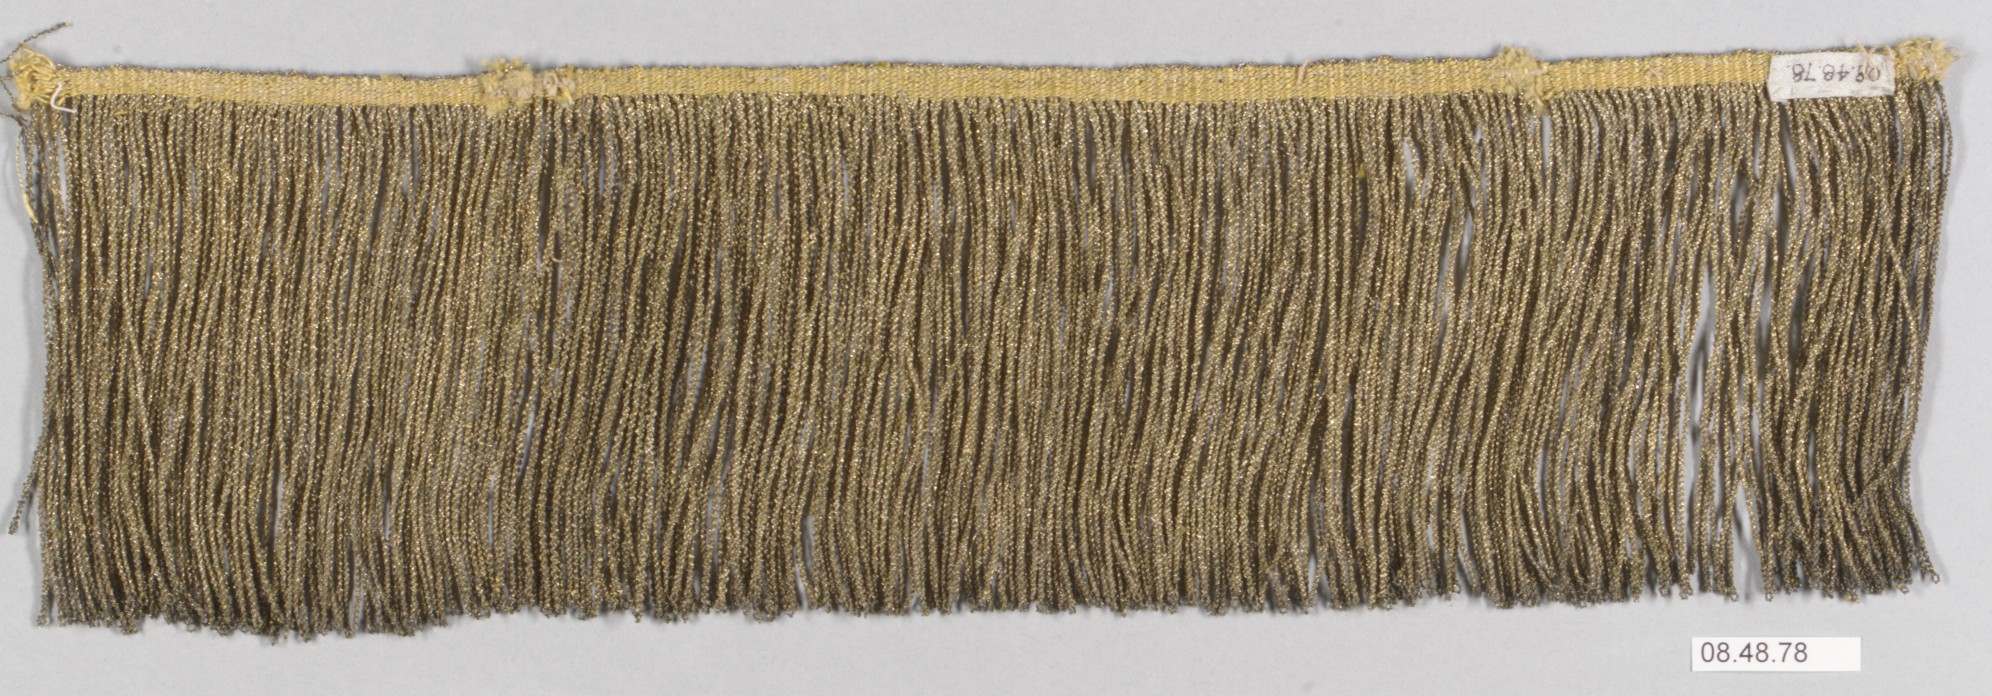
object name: fringe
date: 1767-1800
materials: metal thread